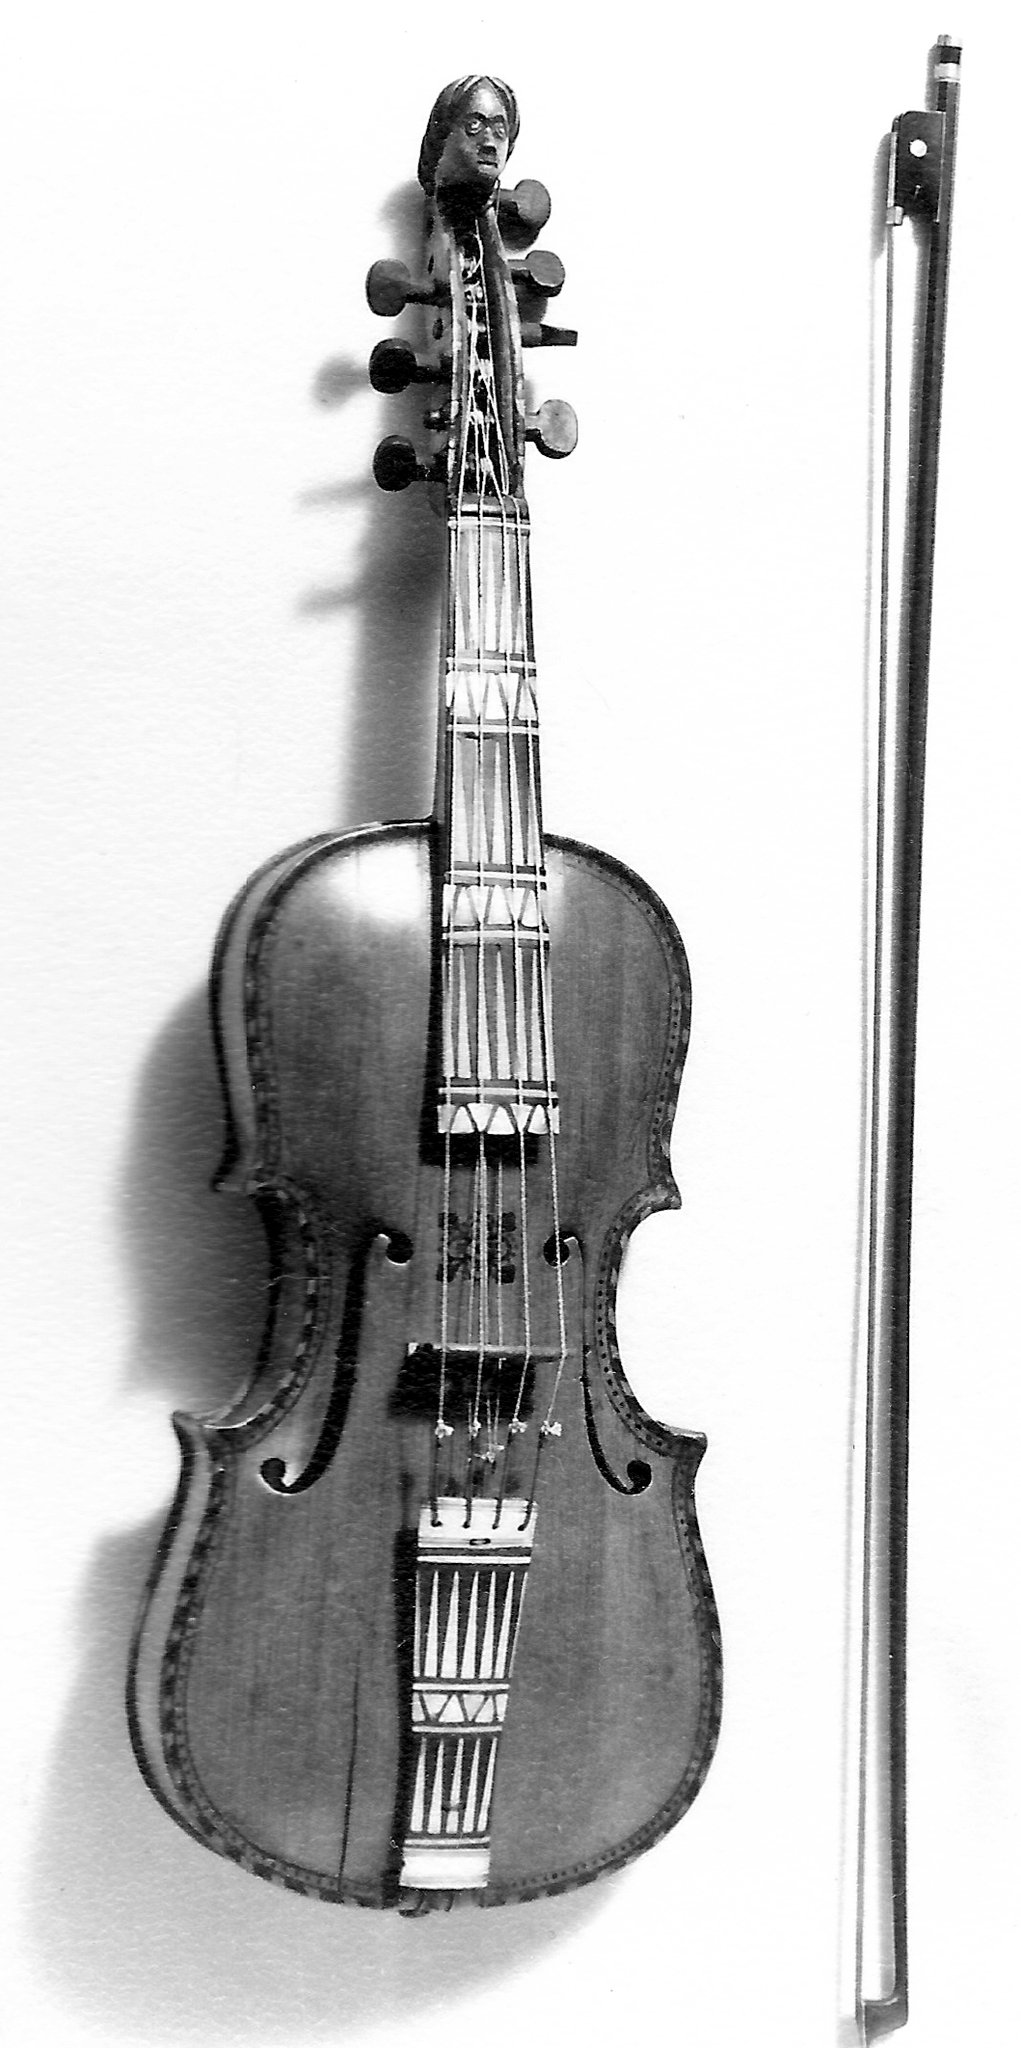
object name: bow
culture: norwegian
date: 1801-1900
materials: hair, wood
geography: norway